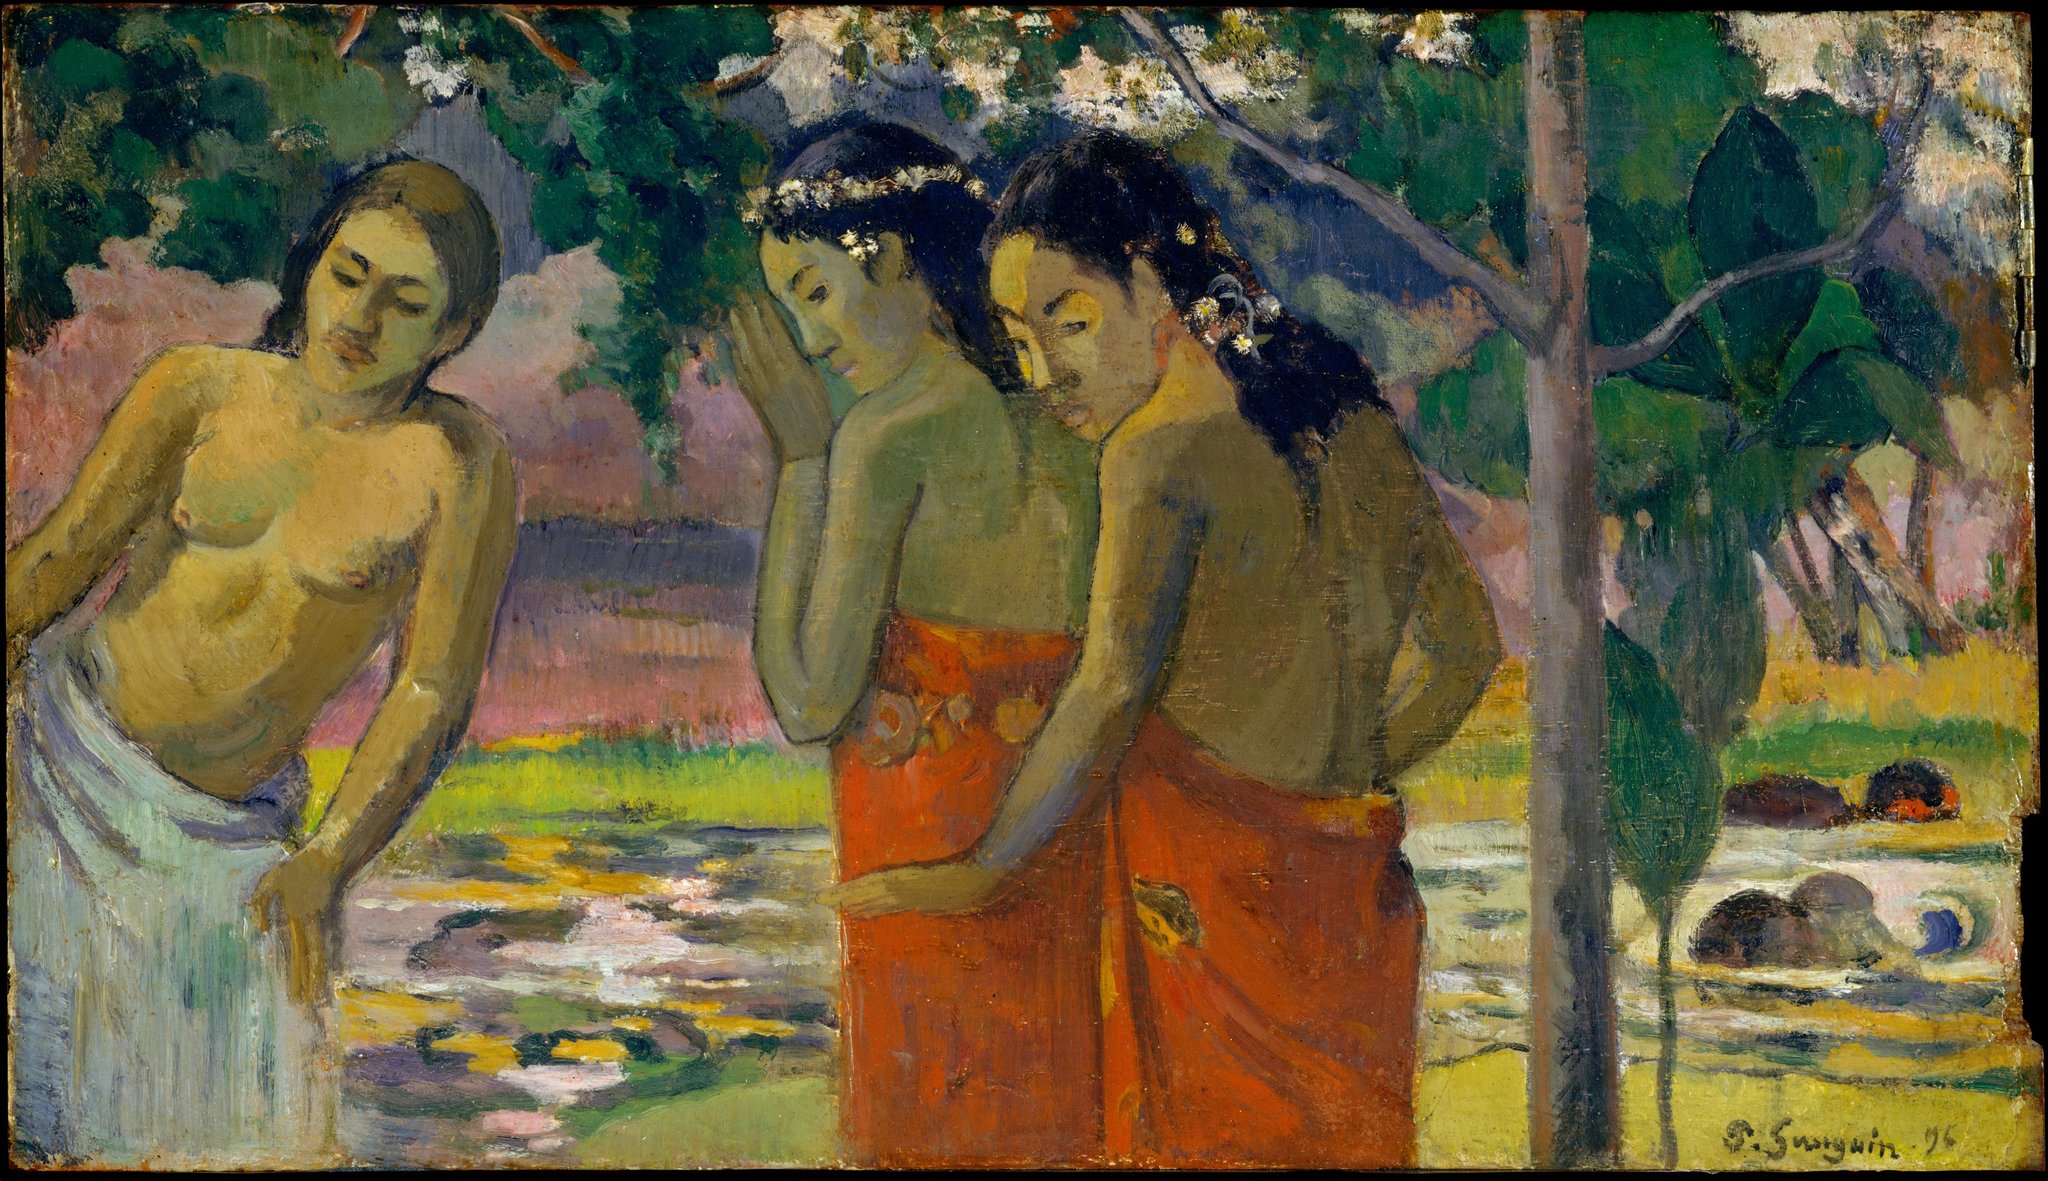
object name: painting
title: Three Tahitian Women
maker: paul gauguin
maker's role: artist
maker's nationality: french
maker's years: 1848-1903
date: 1896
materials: oil, wood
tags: women,female nudes